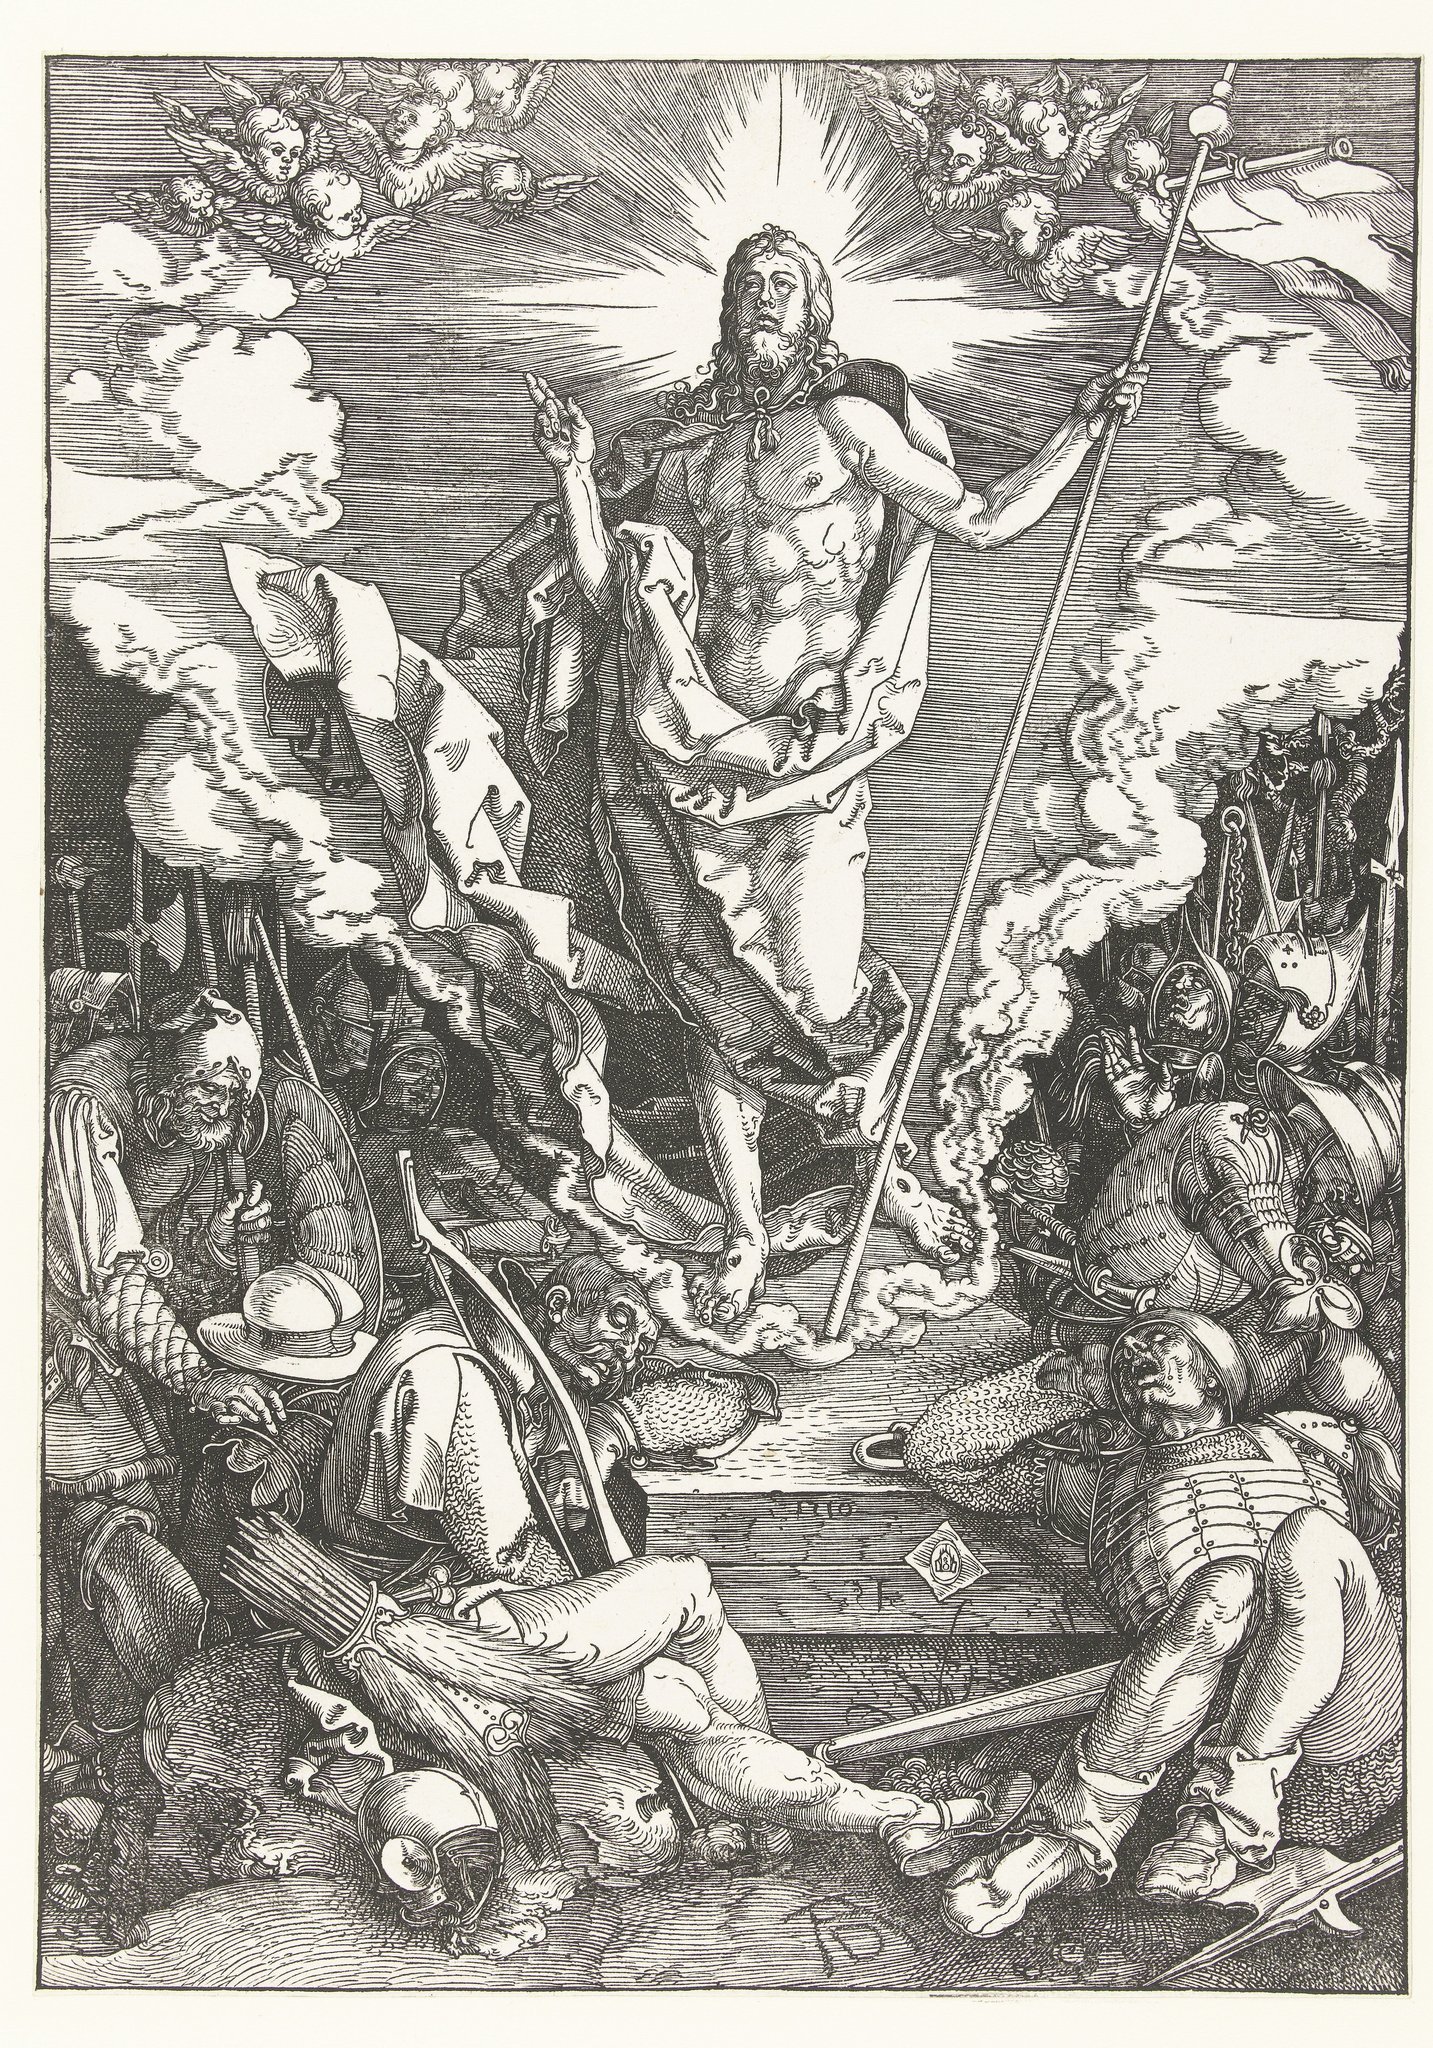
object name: print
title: Opstanding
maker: albrecht dürer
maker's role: draughtsman, painter, print maker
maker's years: 1471-1528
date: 1510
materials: paper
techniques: woodcut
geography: nuremberg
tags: christ, usually holding a banner, arises from the grave; often combined with sleeping and/or frightened soldiers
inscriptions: collector's mark: Lugt 240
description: Christus, een staf met een vaan in de hand, staat op uit zijn graf. Een aantal slapende soldaten zit eromheen. Deze prent is onderdeel van de prentserie 'De grote Passie', bestaande uit een titelprent en 11 scènes uit het Lijdensverhaal.